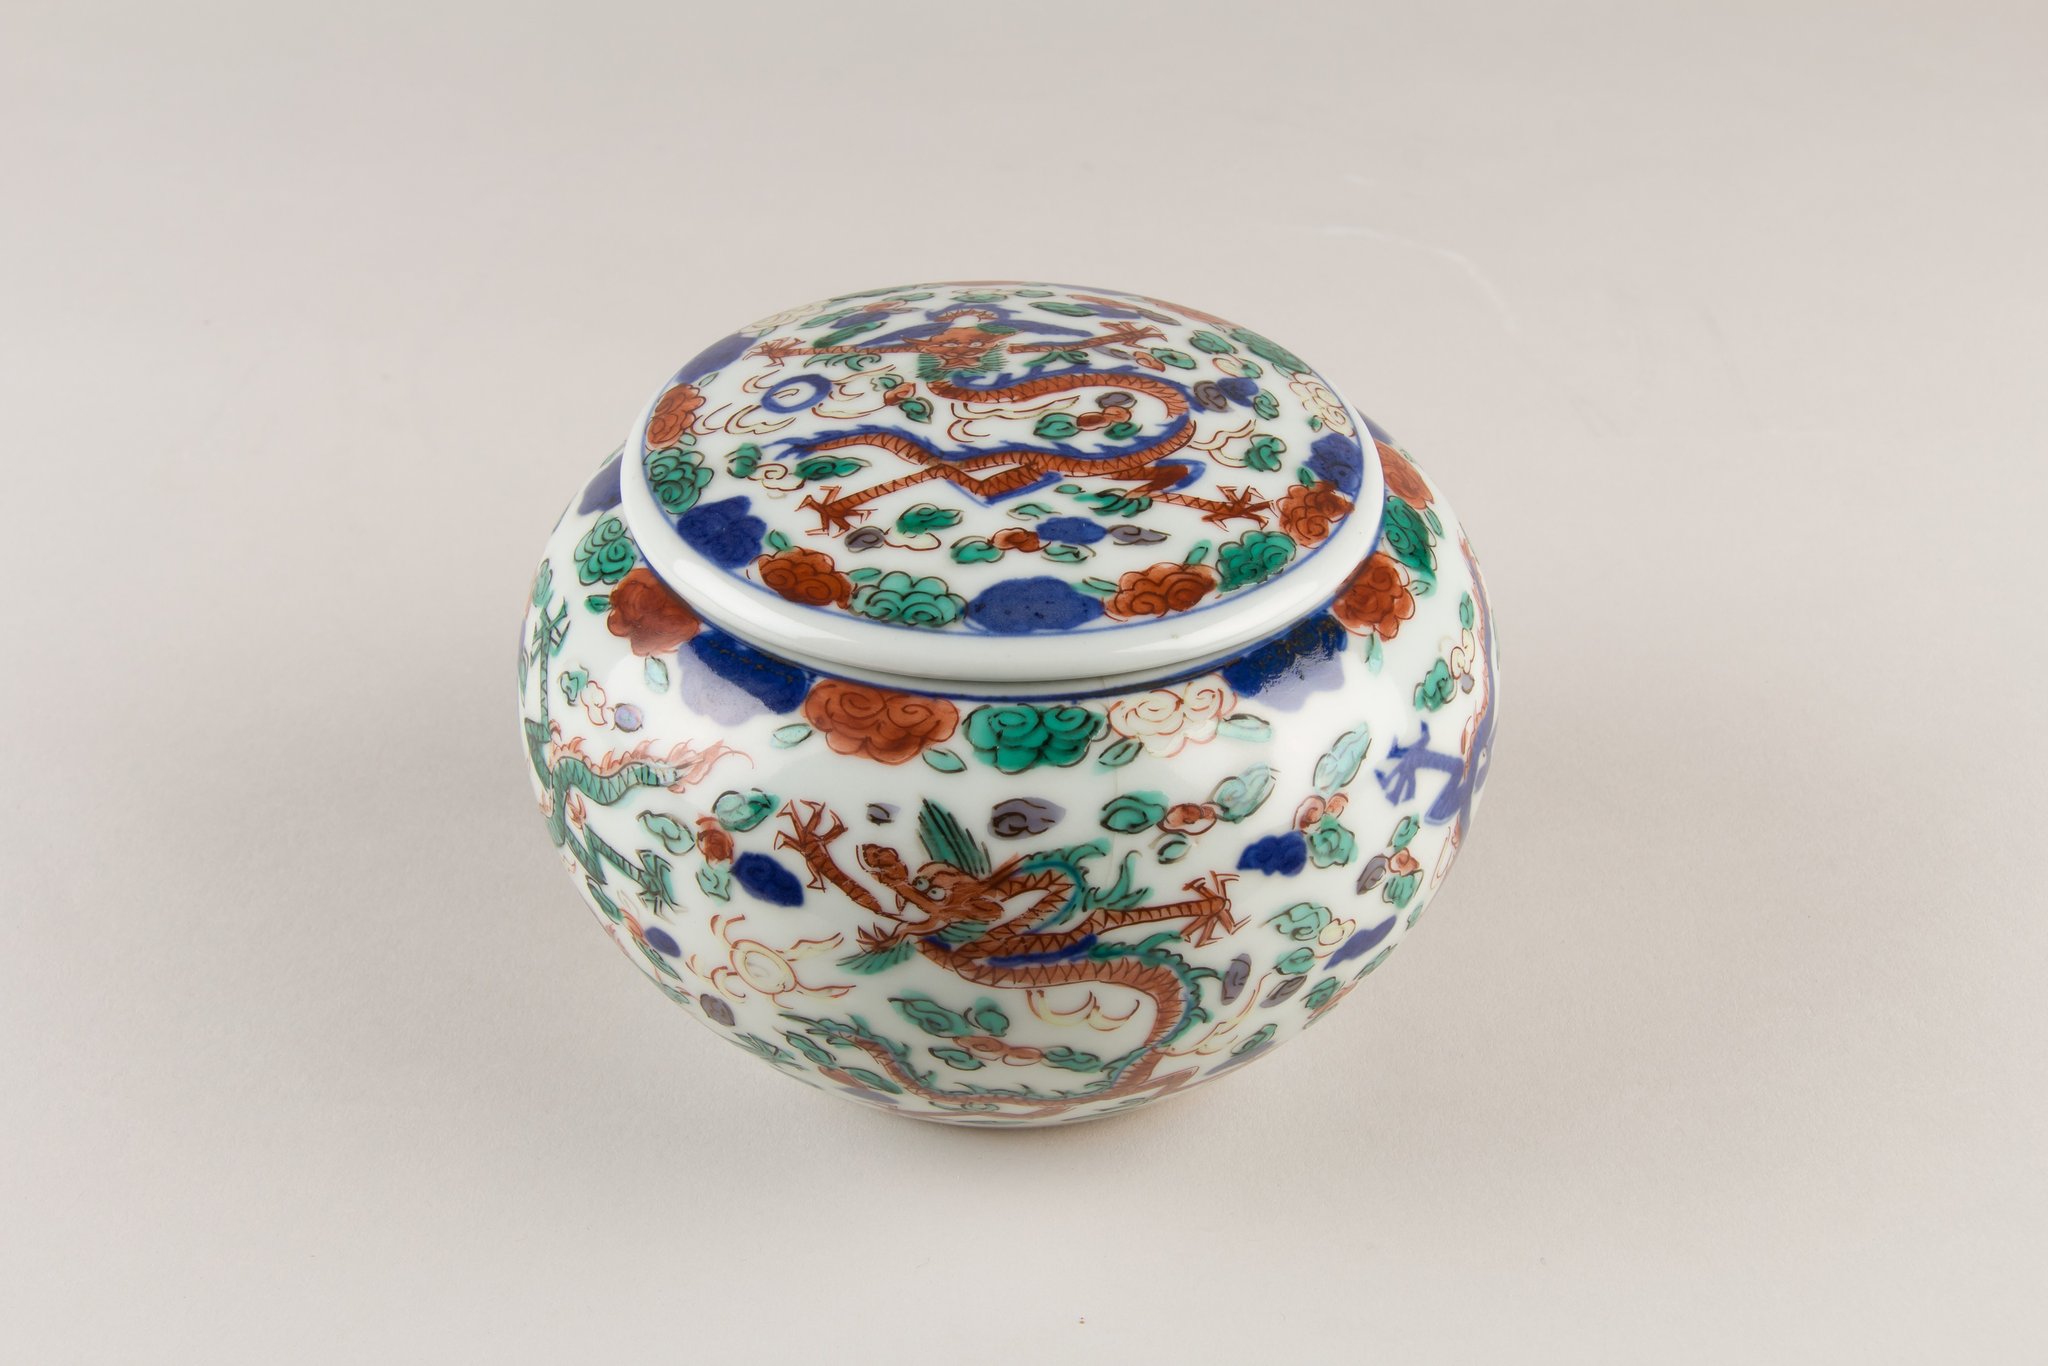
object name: bowl with cover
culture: chinese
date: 1573-1620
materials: porcelain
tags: dragons